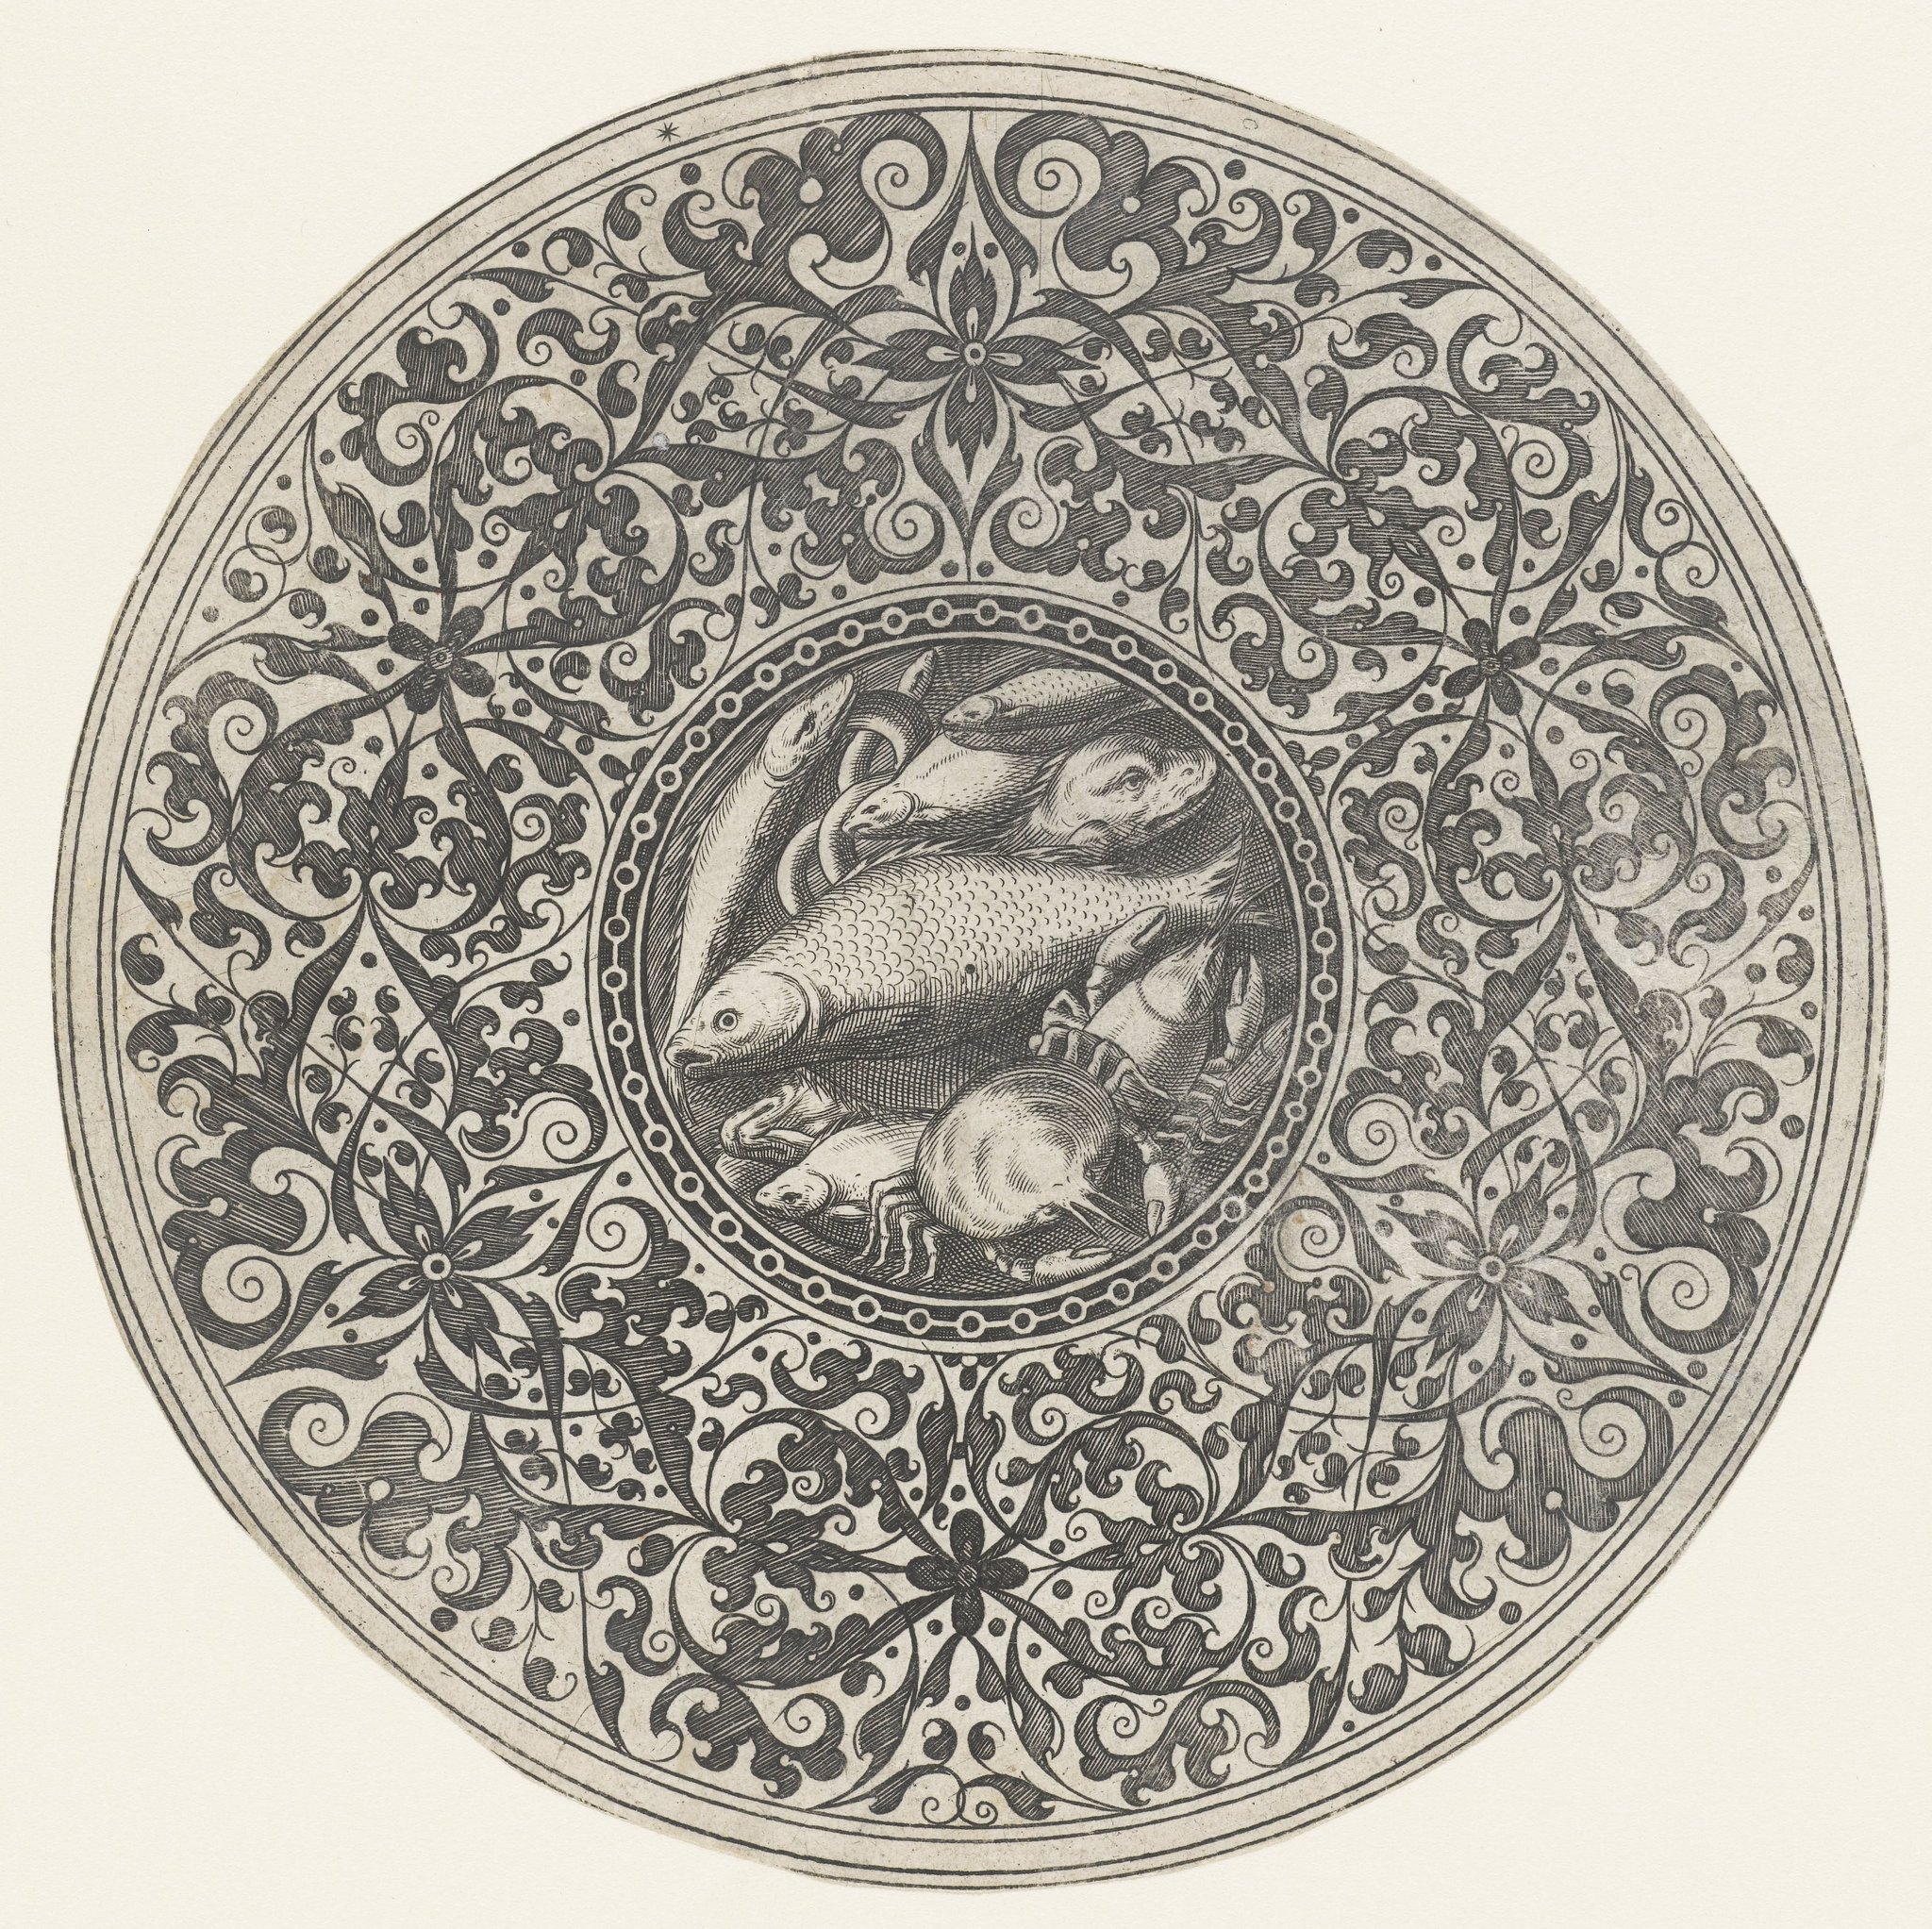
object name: ornament print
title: Schaal met zeedieren en moresken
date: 1604-1620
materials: paper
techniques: engraving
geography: france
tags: ornament ~ moresque, crustaceans: crab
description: Ronde schaal met medaillon met vis en schelpdieren in het midden, omgeven door een brede rand van moresken. Uit serie van 4 bladen.